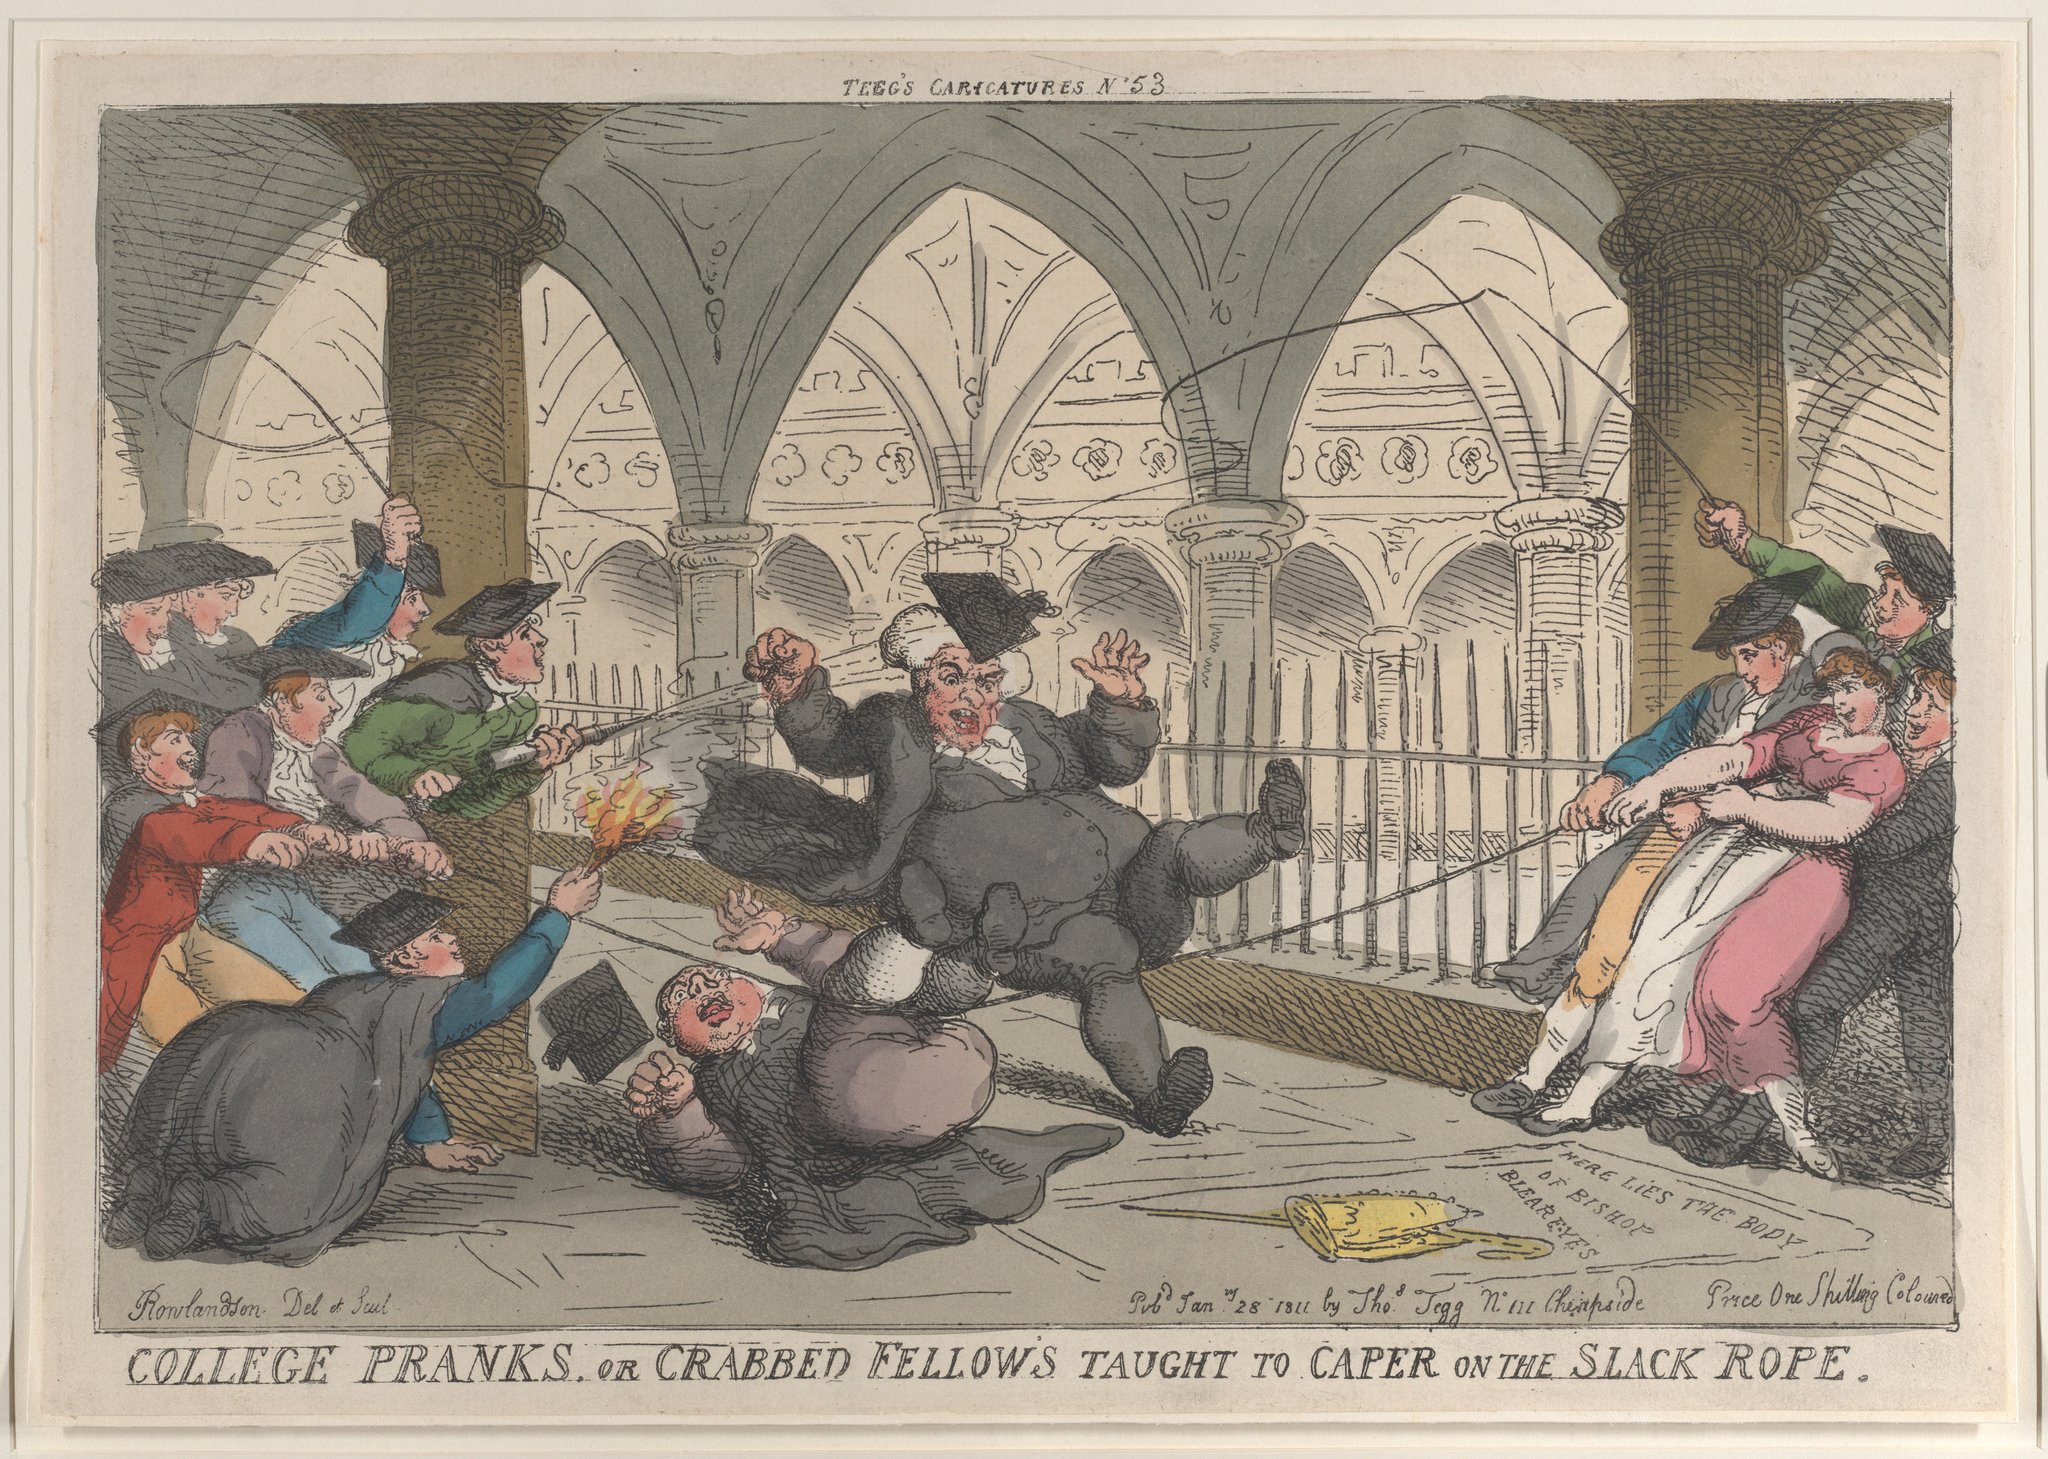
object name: print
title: College Pranks or Crabbed Fellows Taught to Caper on the Slack Rope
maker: thomas rowlandson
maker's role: artist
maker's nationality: british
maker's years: 1757-1827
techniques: etching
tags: satire,men,women,students